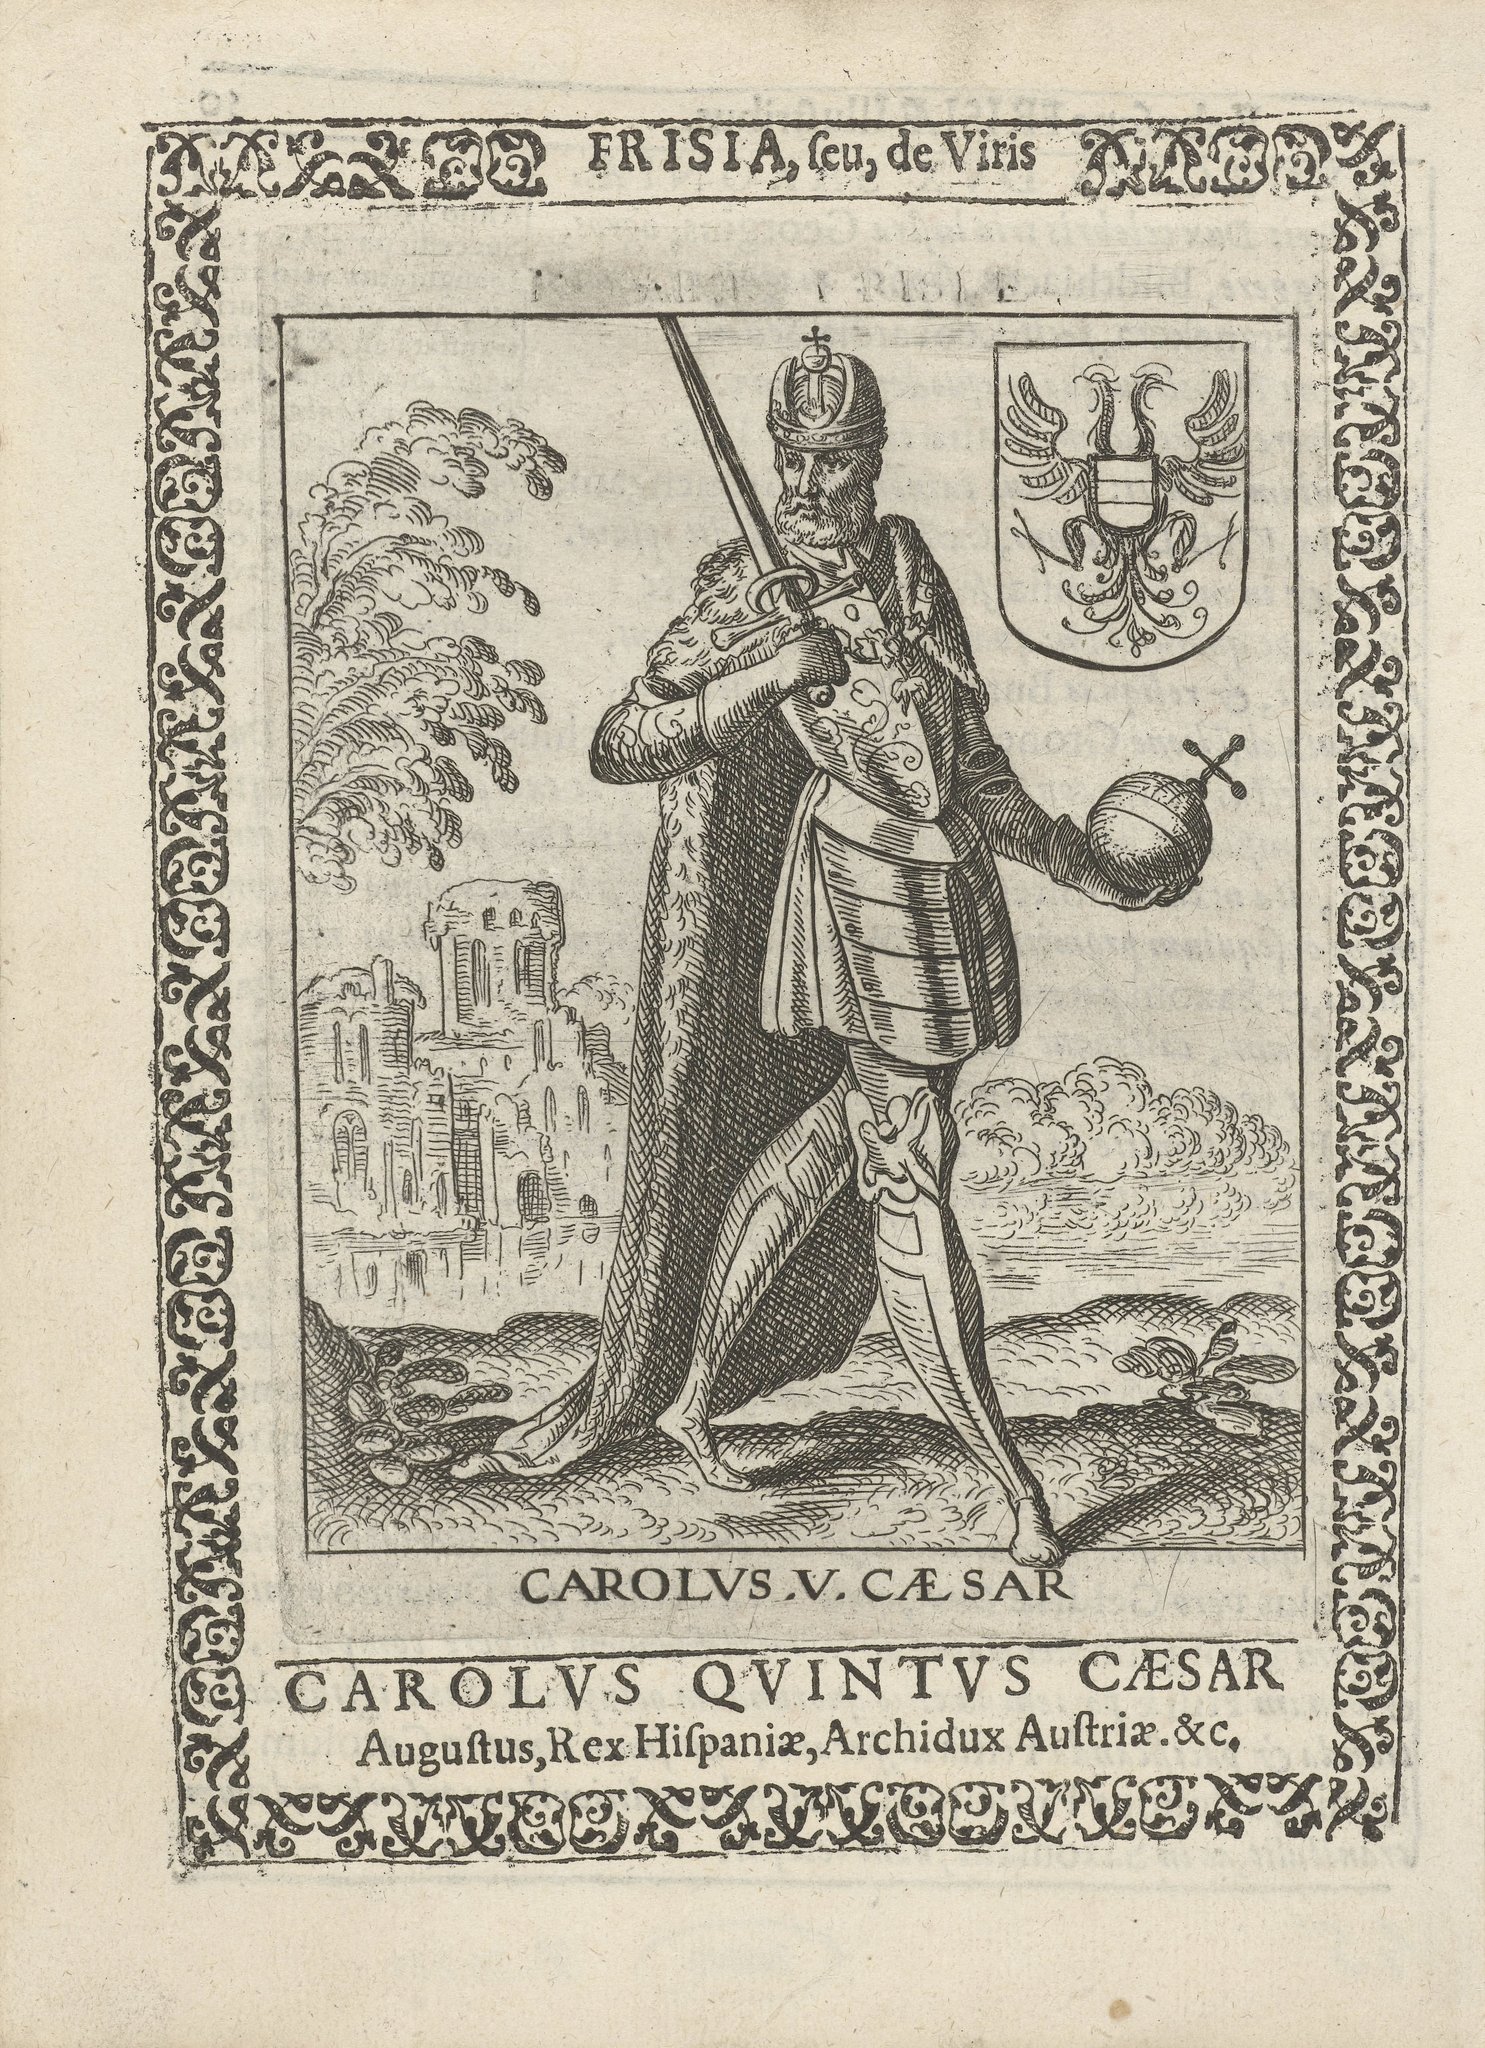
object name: print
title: Frisia, sev, de Viris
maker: pieter feddes van harlingen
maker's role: painter, print maker, publisher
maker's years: 1586-1623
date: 1618-1620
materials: paper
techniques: etching, letterpress printing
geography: friesland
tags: ghent, charles v (holy roman emperor and king of spain), ruler, sovereign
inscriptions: collector's mark: Lugt 2228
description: Karel V, erfpotestaat van Friesland. Staande ten voeten uit, zwaard en rijksappel in de hand. Illustratie, met tekst op achterzijde, afkomstig uit het boek: Frisia seu de viris rebusque Frisiae illustribus libri duo.